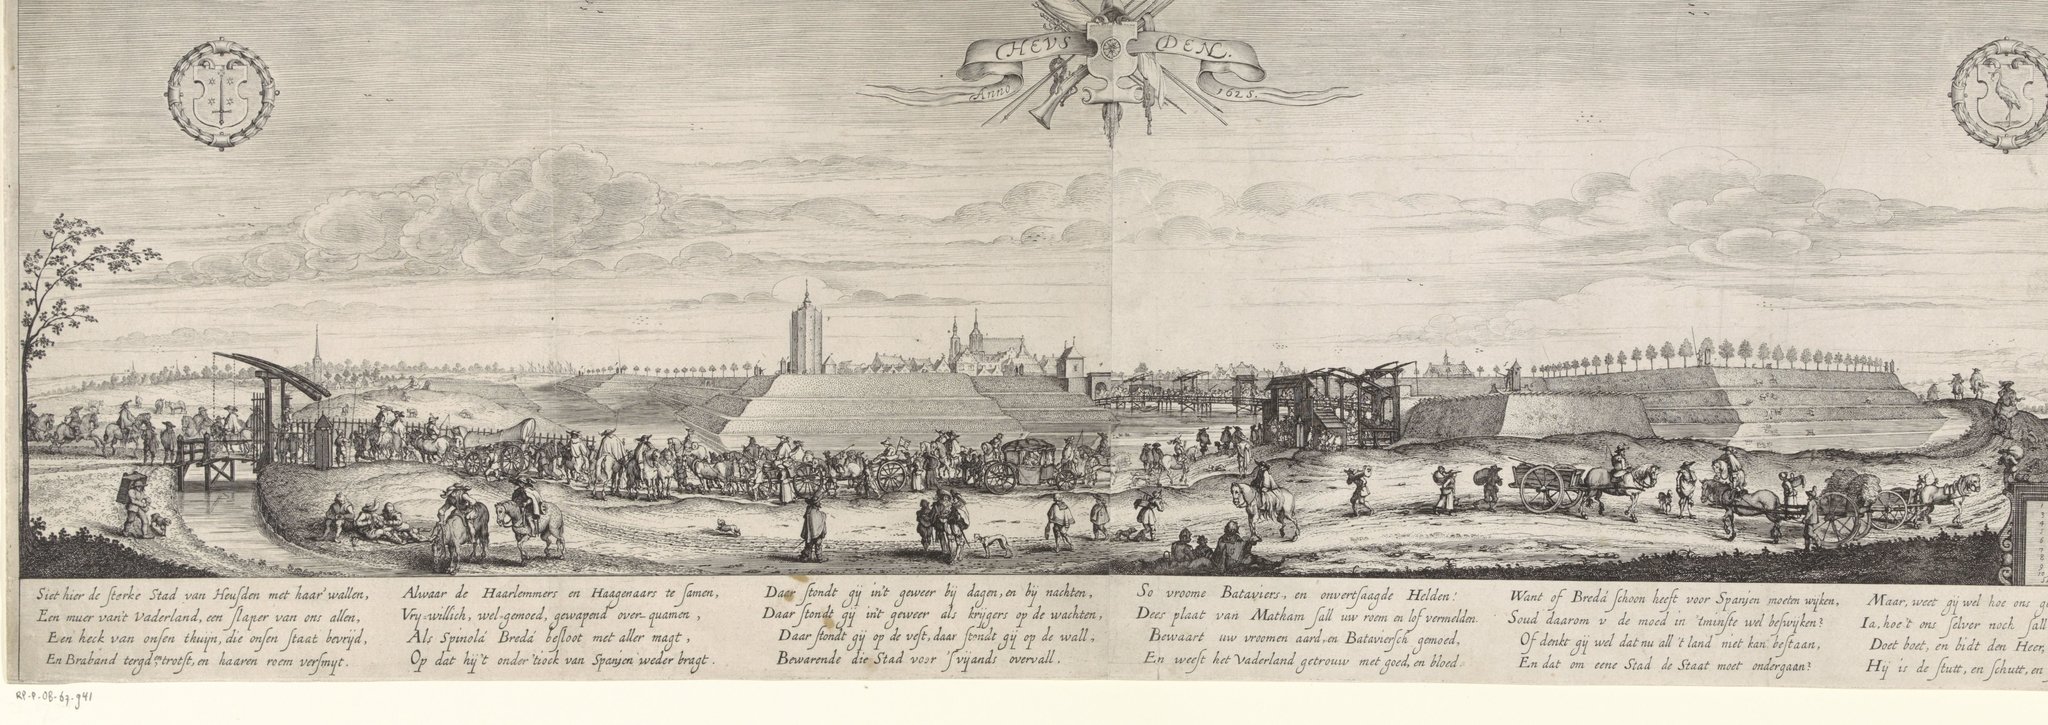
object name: print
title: Haarlemse schutterij bezet Heusden, 1625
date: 1625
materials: paper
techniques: engraving, etching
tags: siege, position war, bridge, two-wheeled vehicle drawn by one animal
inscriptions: collector's mark: Lugt 240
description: Gezicht op de poort en twee bruggen te Heusden, terwijl deze plaats bezet wordt door de Haarlemse schutterij. Op de voorgrond een stoet met vele met paarden bespannen karren en ruiters.